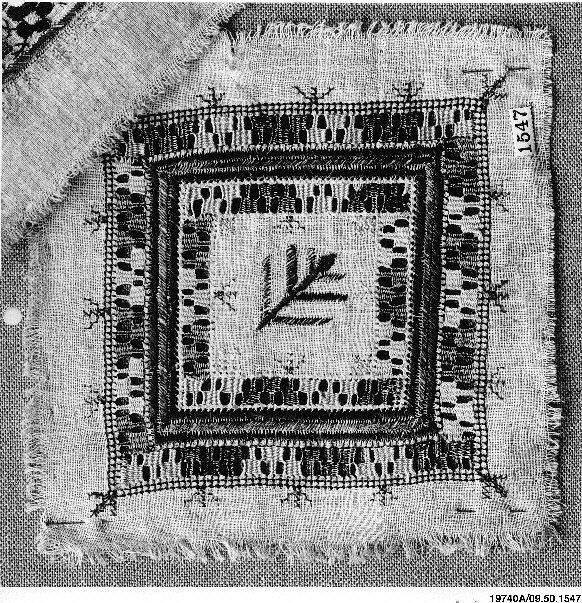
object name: square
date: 1801-1900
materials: cotton, metal thread, silk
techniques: embroidery, weave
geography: turkey